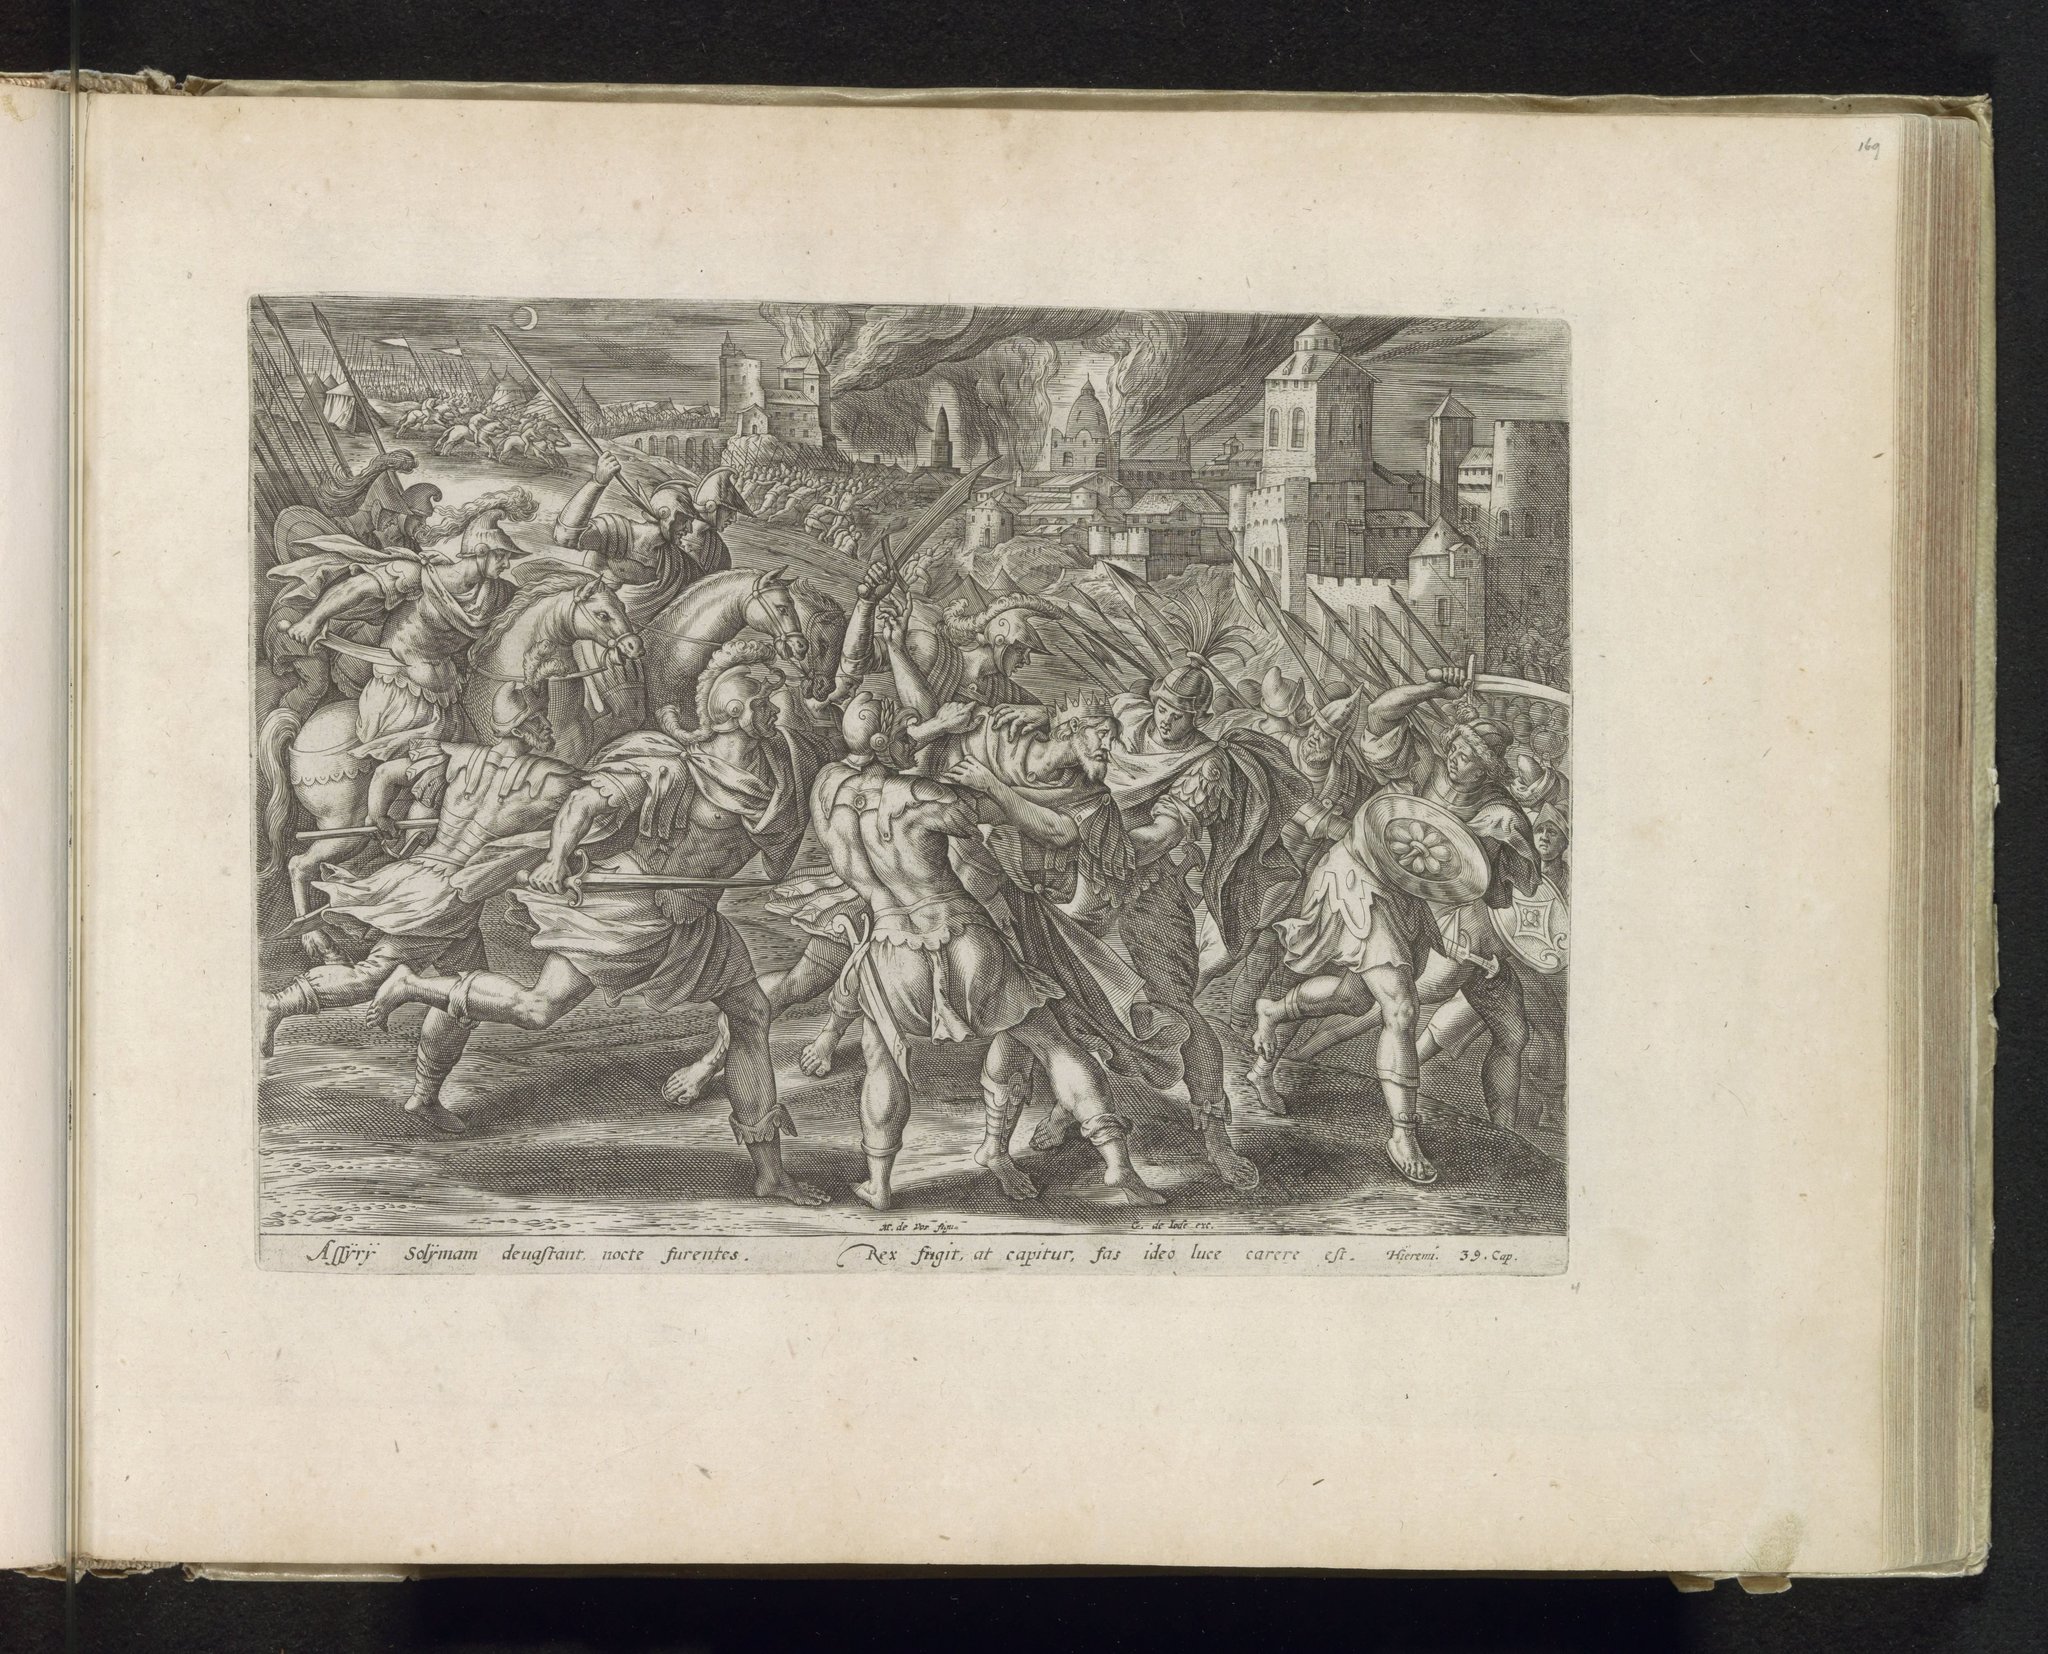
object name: album leaf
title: Geschiedenis van Jeremia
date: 1585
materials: paper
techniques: engraving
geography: antwerp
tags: zedekiah is captured by the babylonians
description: Als koning Sedekia ’s nachts de stad uitvlucht in de richting van de Jordaanvallei wordt hij door het Chaldese leger op de vlakte van Jericho gevangen genomen. Onder de voorstelling een verwijzing in het Latijn naar de Bijbeltekst in Jer. 39. Deze prent maakt deel uit van een album.